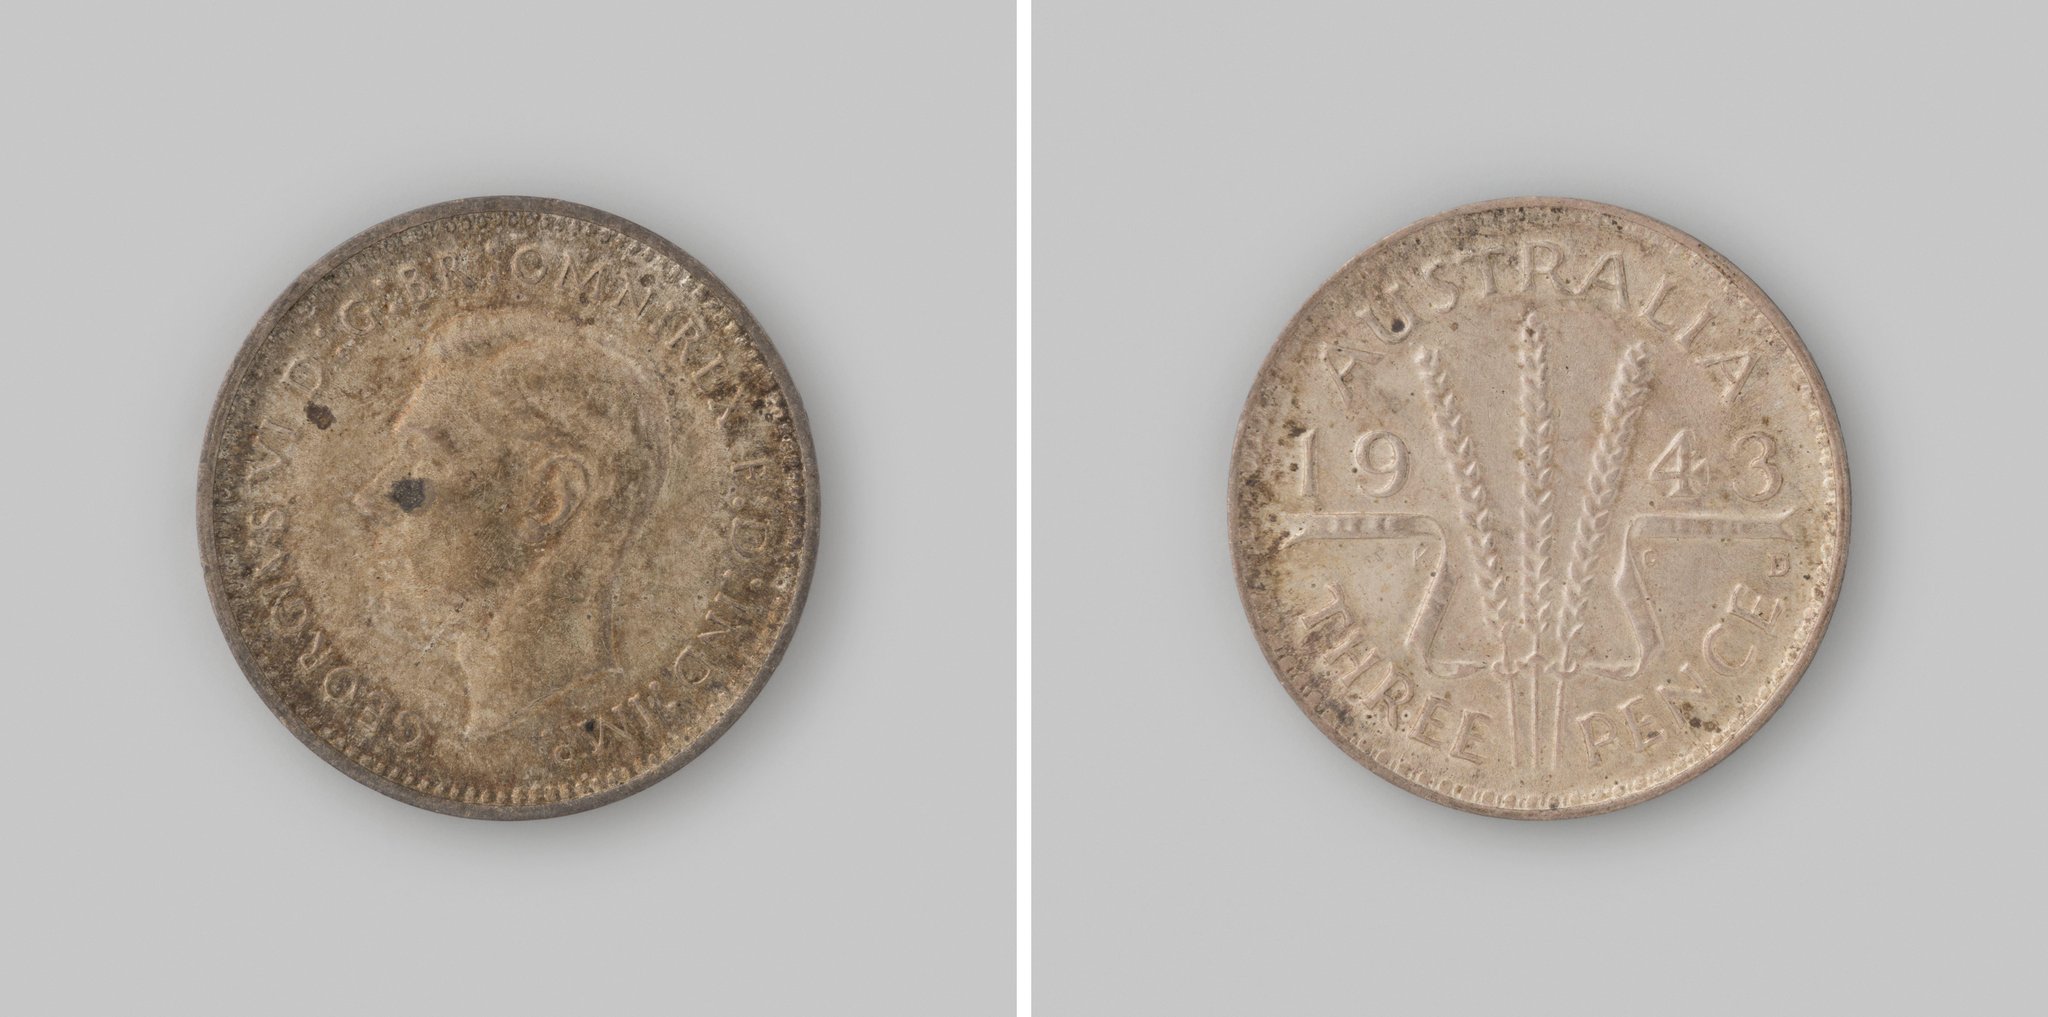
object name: coin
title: Australië, koning George VI, 3 pence, 1943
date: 1943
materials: silver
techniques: striking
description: Zilveren munt. Voorzijde: hoofd van de koning naar links. Keerzijde: tussen jaartal drie met lint samengebonden korenaren. Lands-aanduiding bovenaan en waarde-aanduiding onderaan als omschrift. Gladde rand.